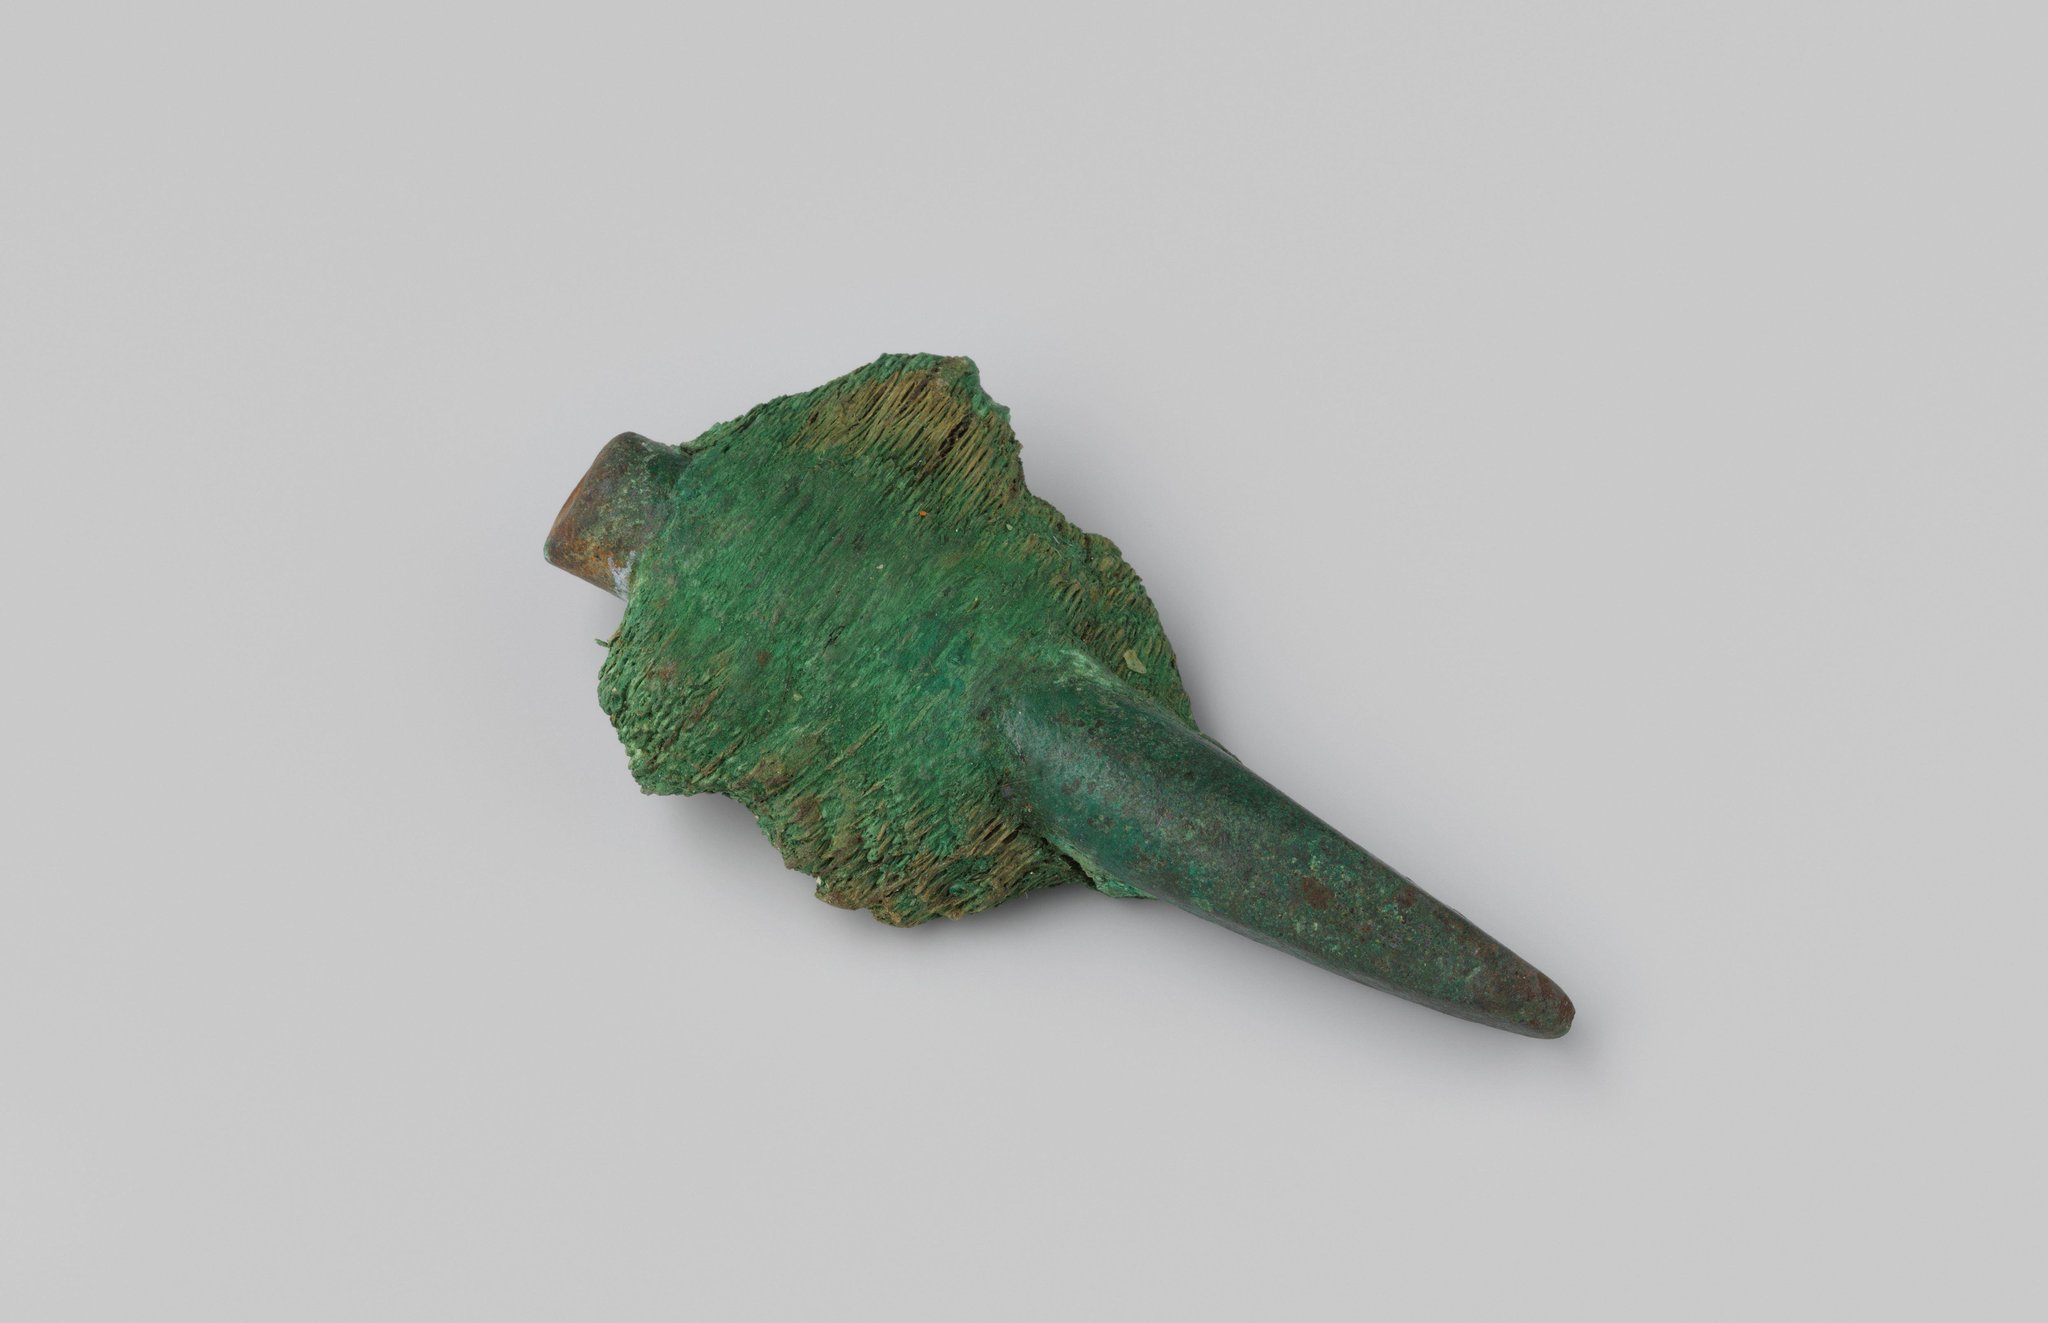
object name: bolt tongs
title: Bout in hout, afkomstig uit het wrak van de Oost-Indiëvaarder Hollandia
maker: Anonymous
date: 1700-1743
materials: iron, wood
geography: netherlands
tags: verenigde oostindische compagnie, hollandia (schip)